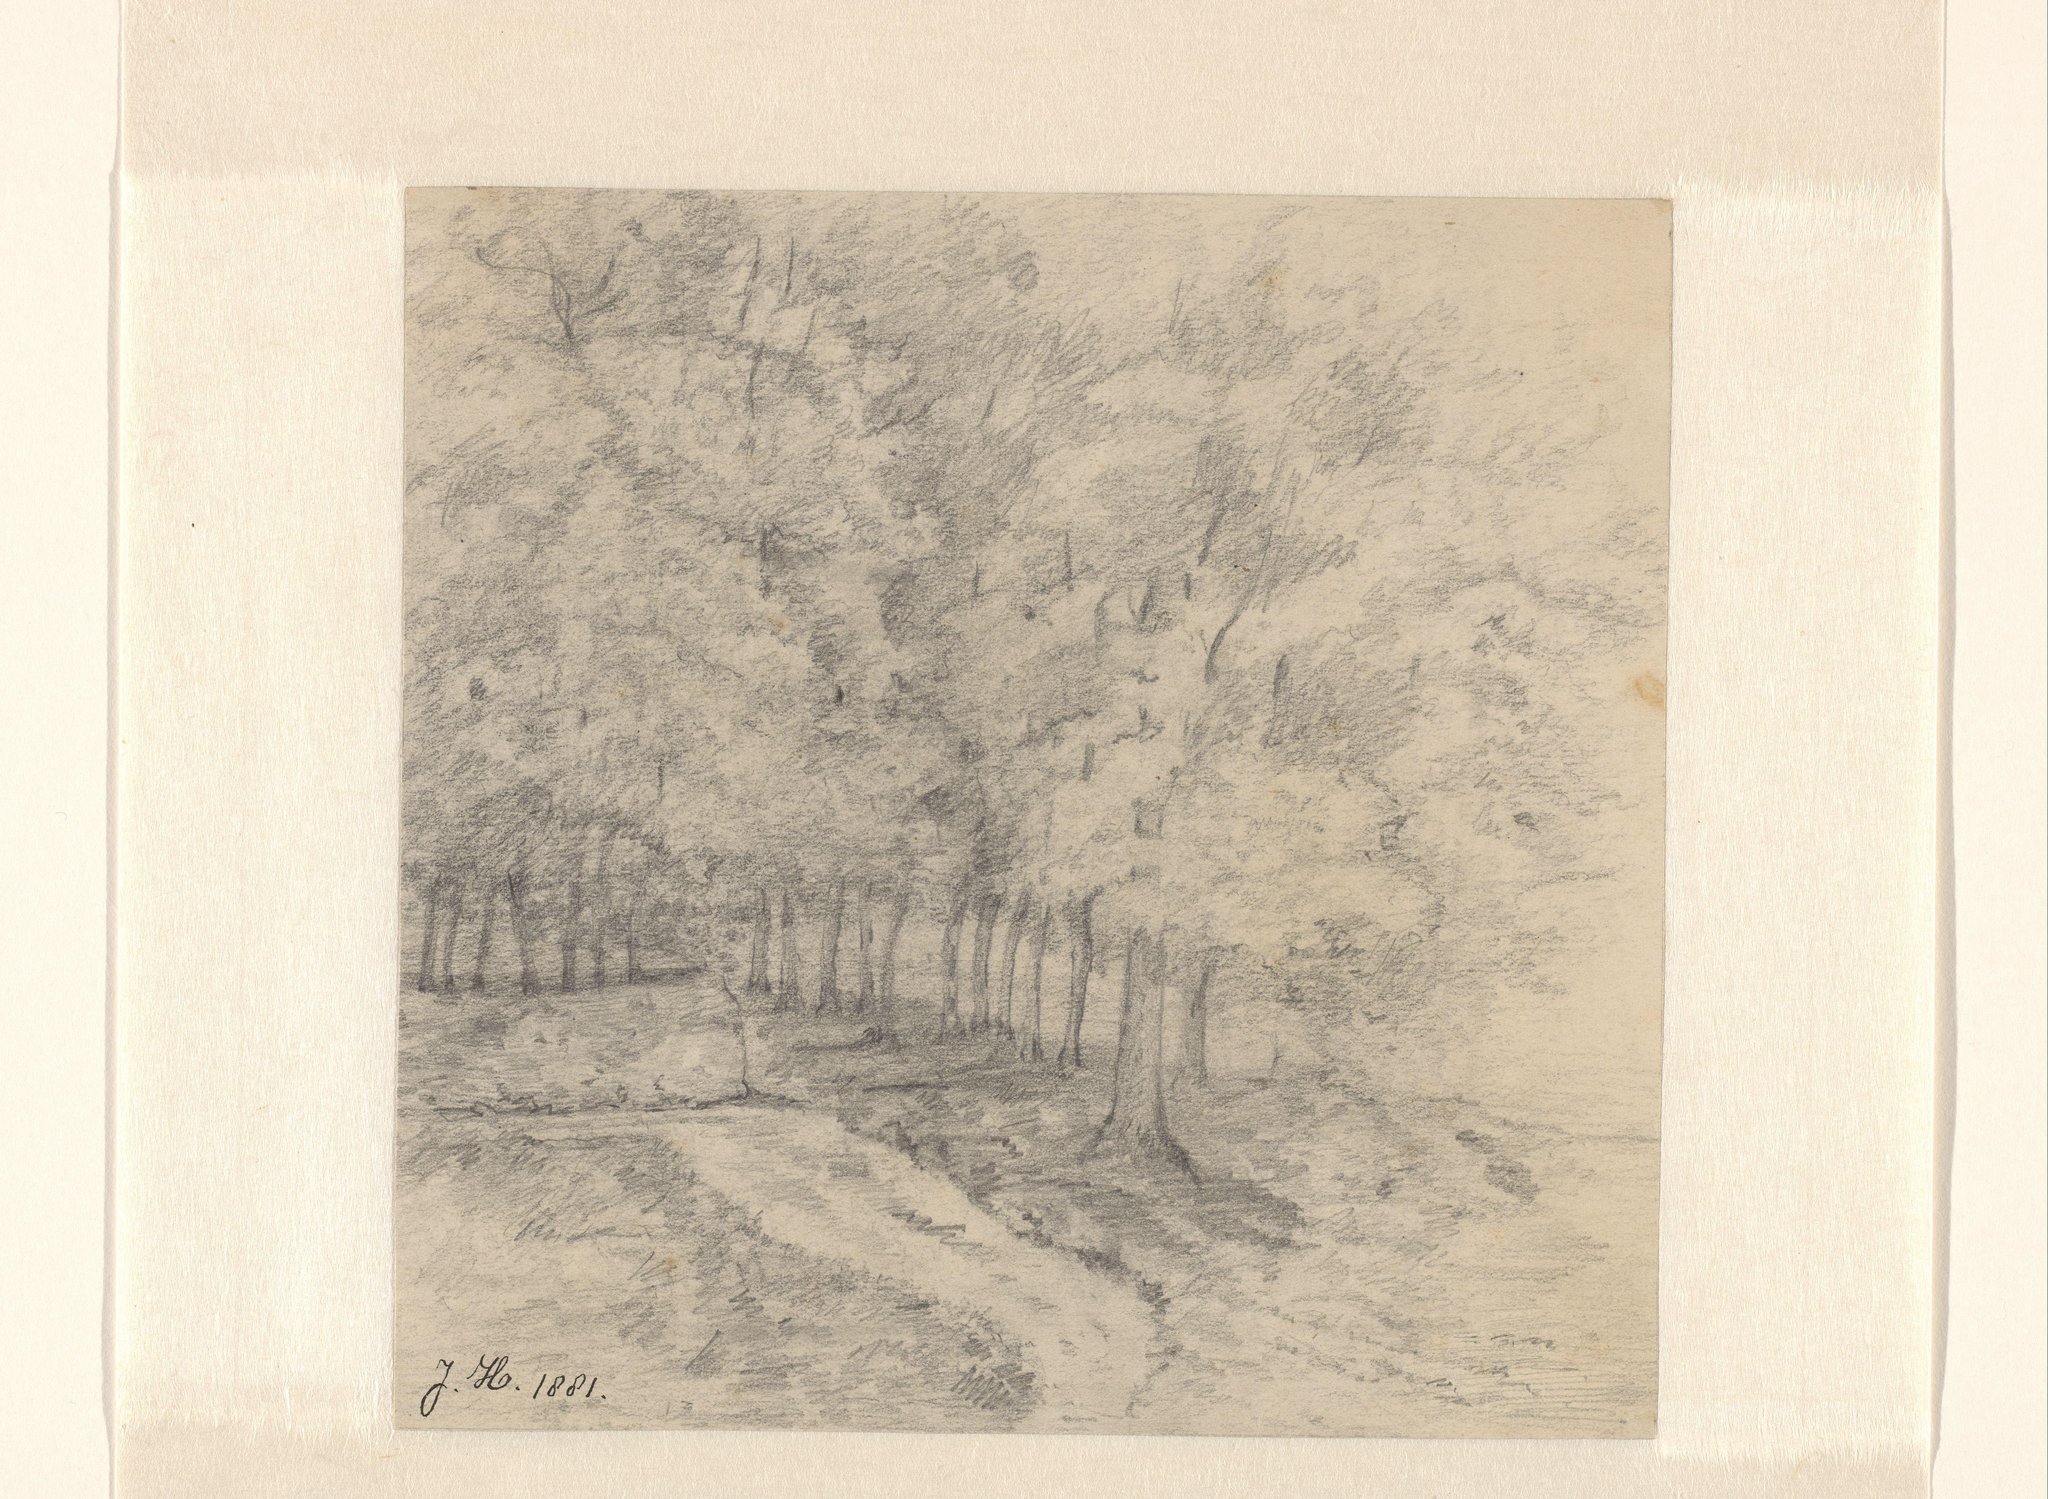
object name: drawing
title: Landschap met bomen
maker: jeanne marie heynsius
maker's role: draughtsman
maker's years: 1860-1920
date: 1881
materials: paper, pencil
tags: trees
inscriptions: collector's mark: Lugt 2228, number: ‘no. 79.’